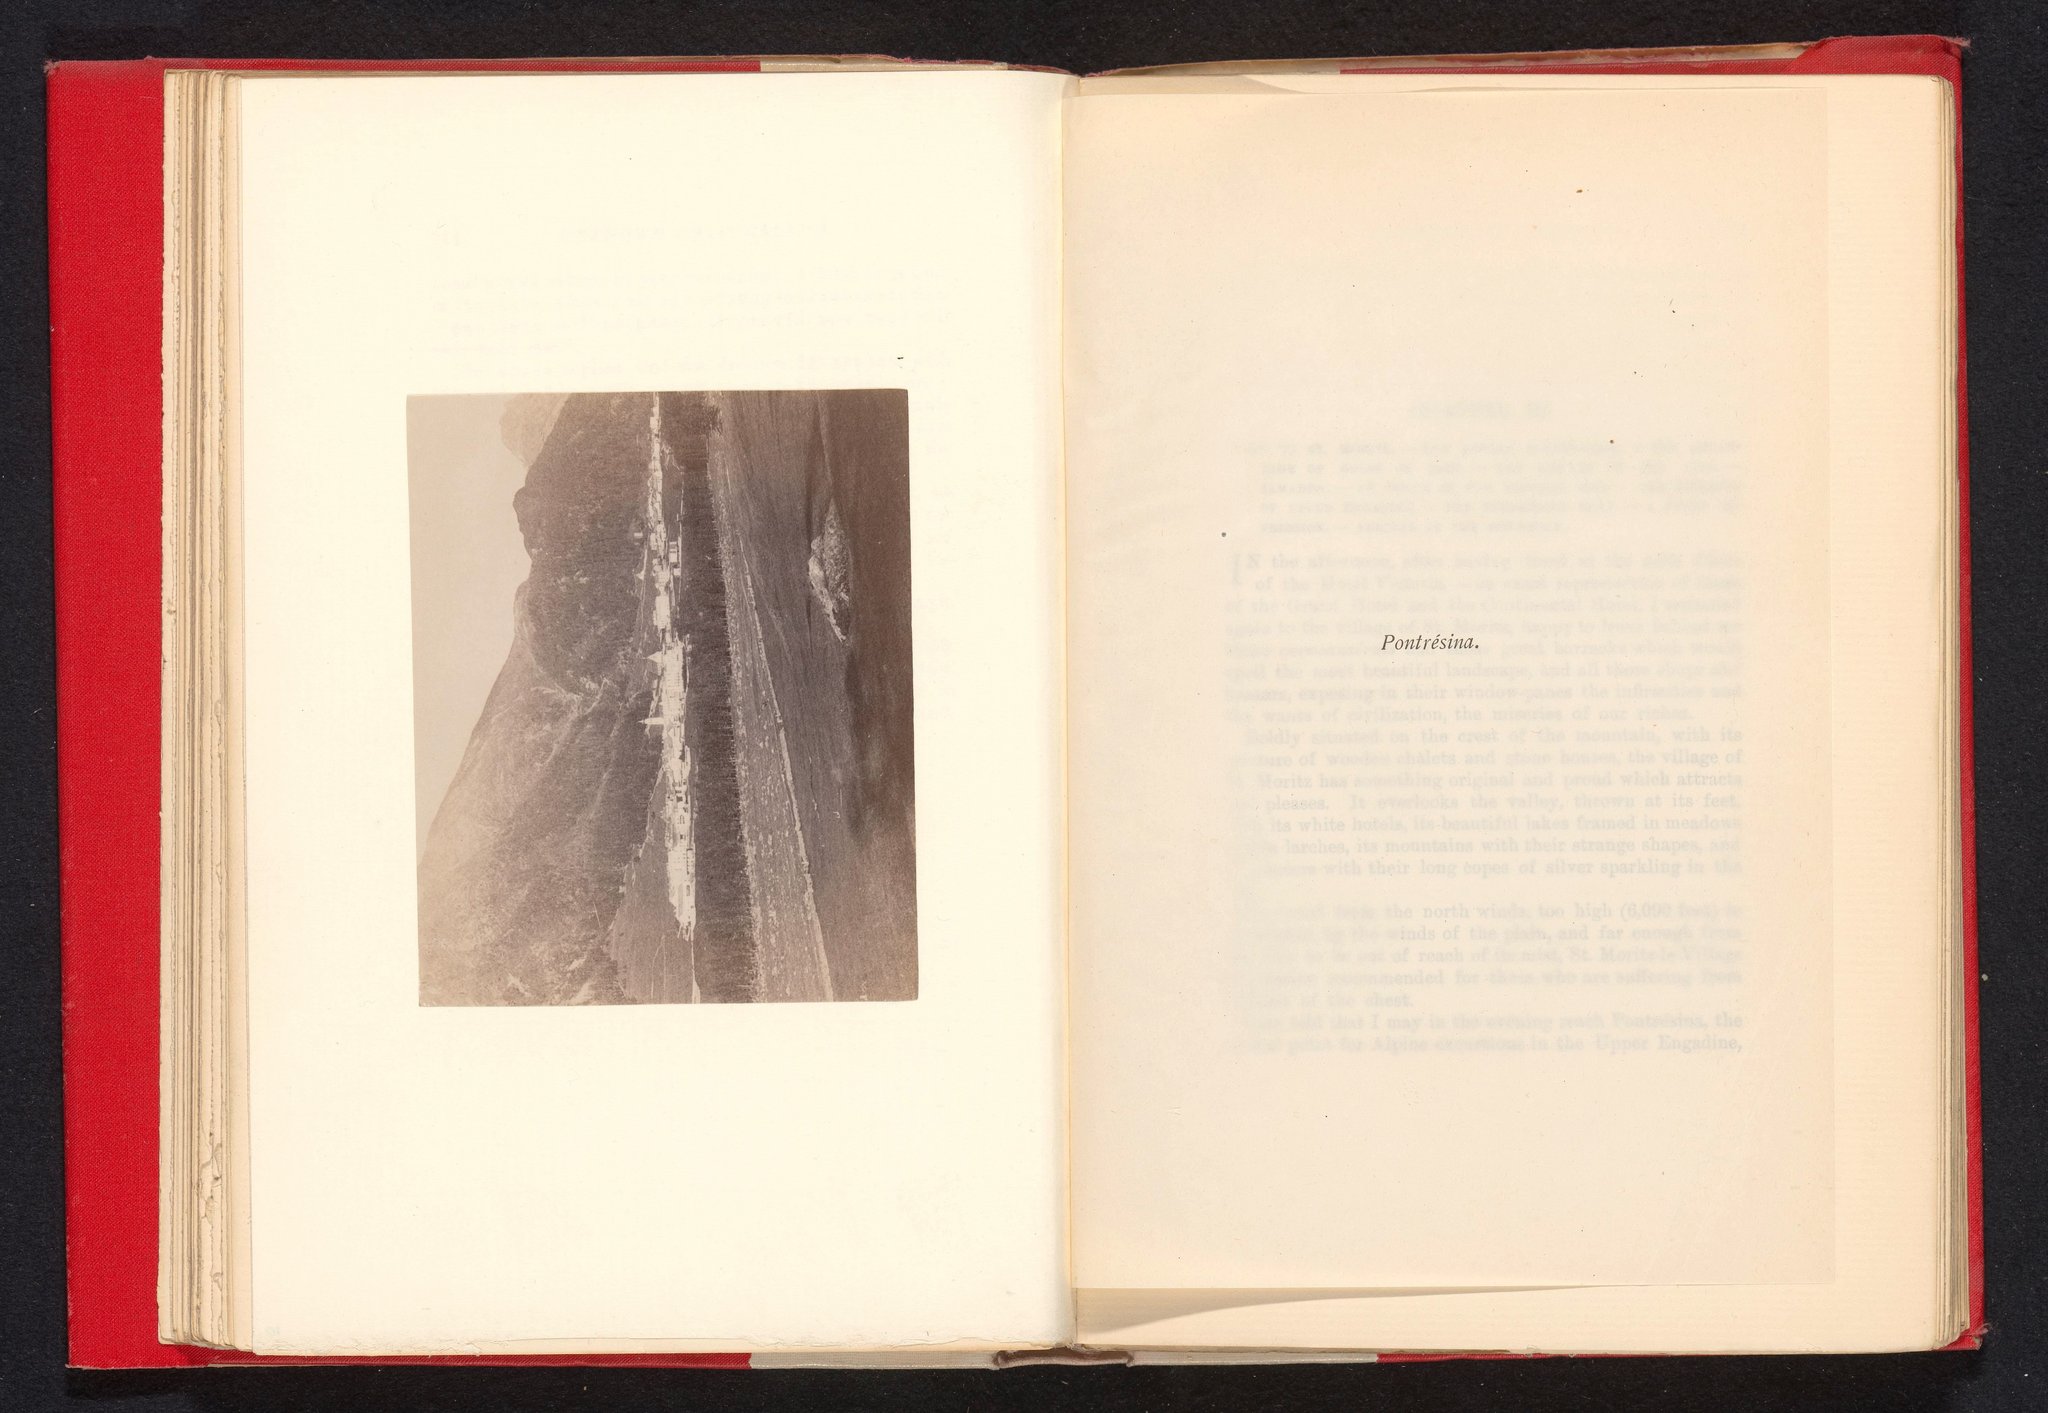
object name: photograph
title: Gezicht op Pontresina in Zwitserland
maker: Anonymous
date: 1879-1889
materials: photographic support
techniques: albumen print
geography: graubunden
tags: city-view, and landscape with man-made constructions, mountains